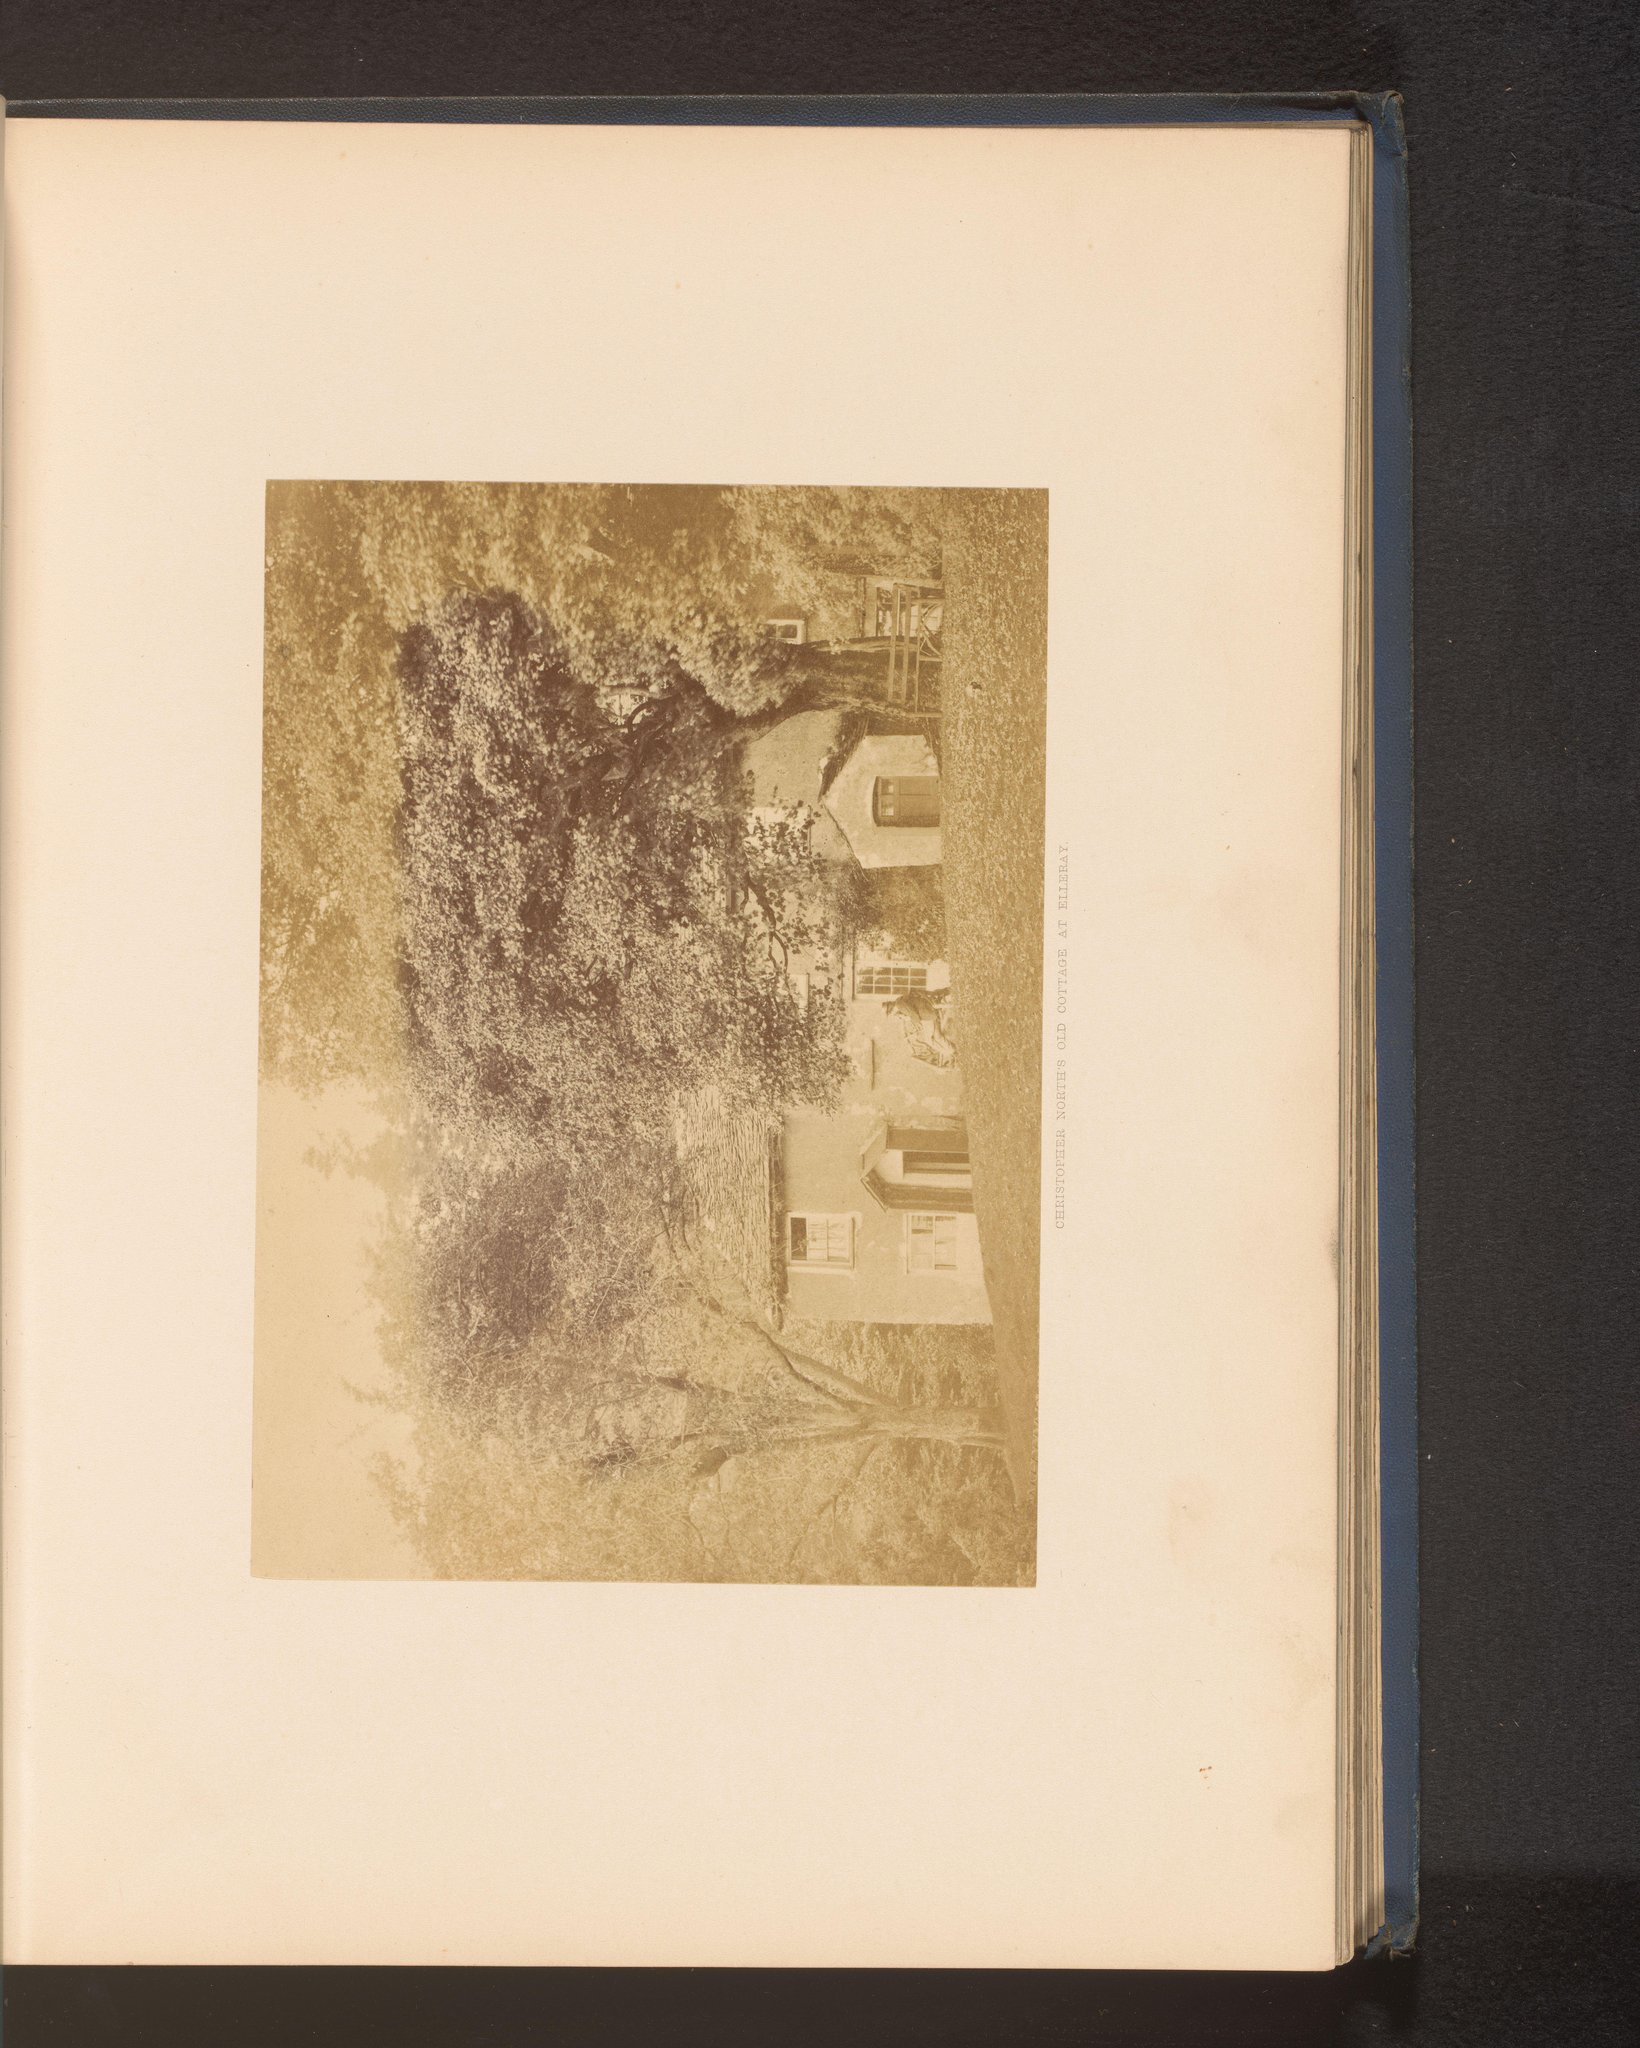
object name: photograph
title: Gezicht op het oude huis van de schrijver John Wilson bij Windermere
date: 1857-1867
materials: photographic support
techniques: albumen print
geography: lake district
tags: cottage